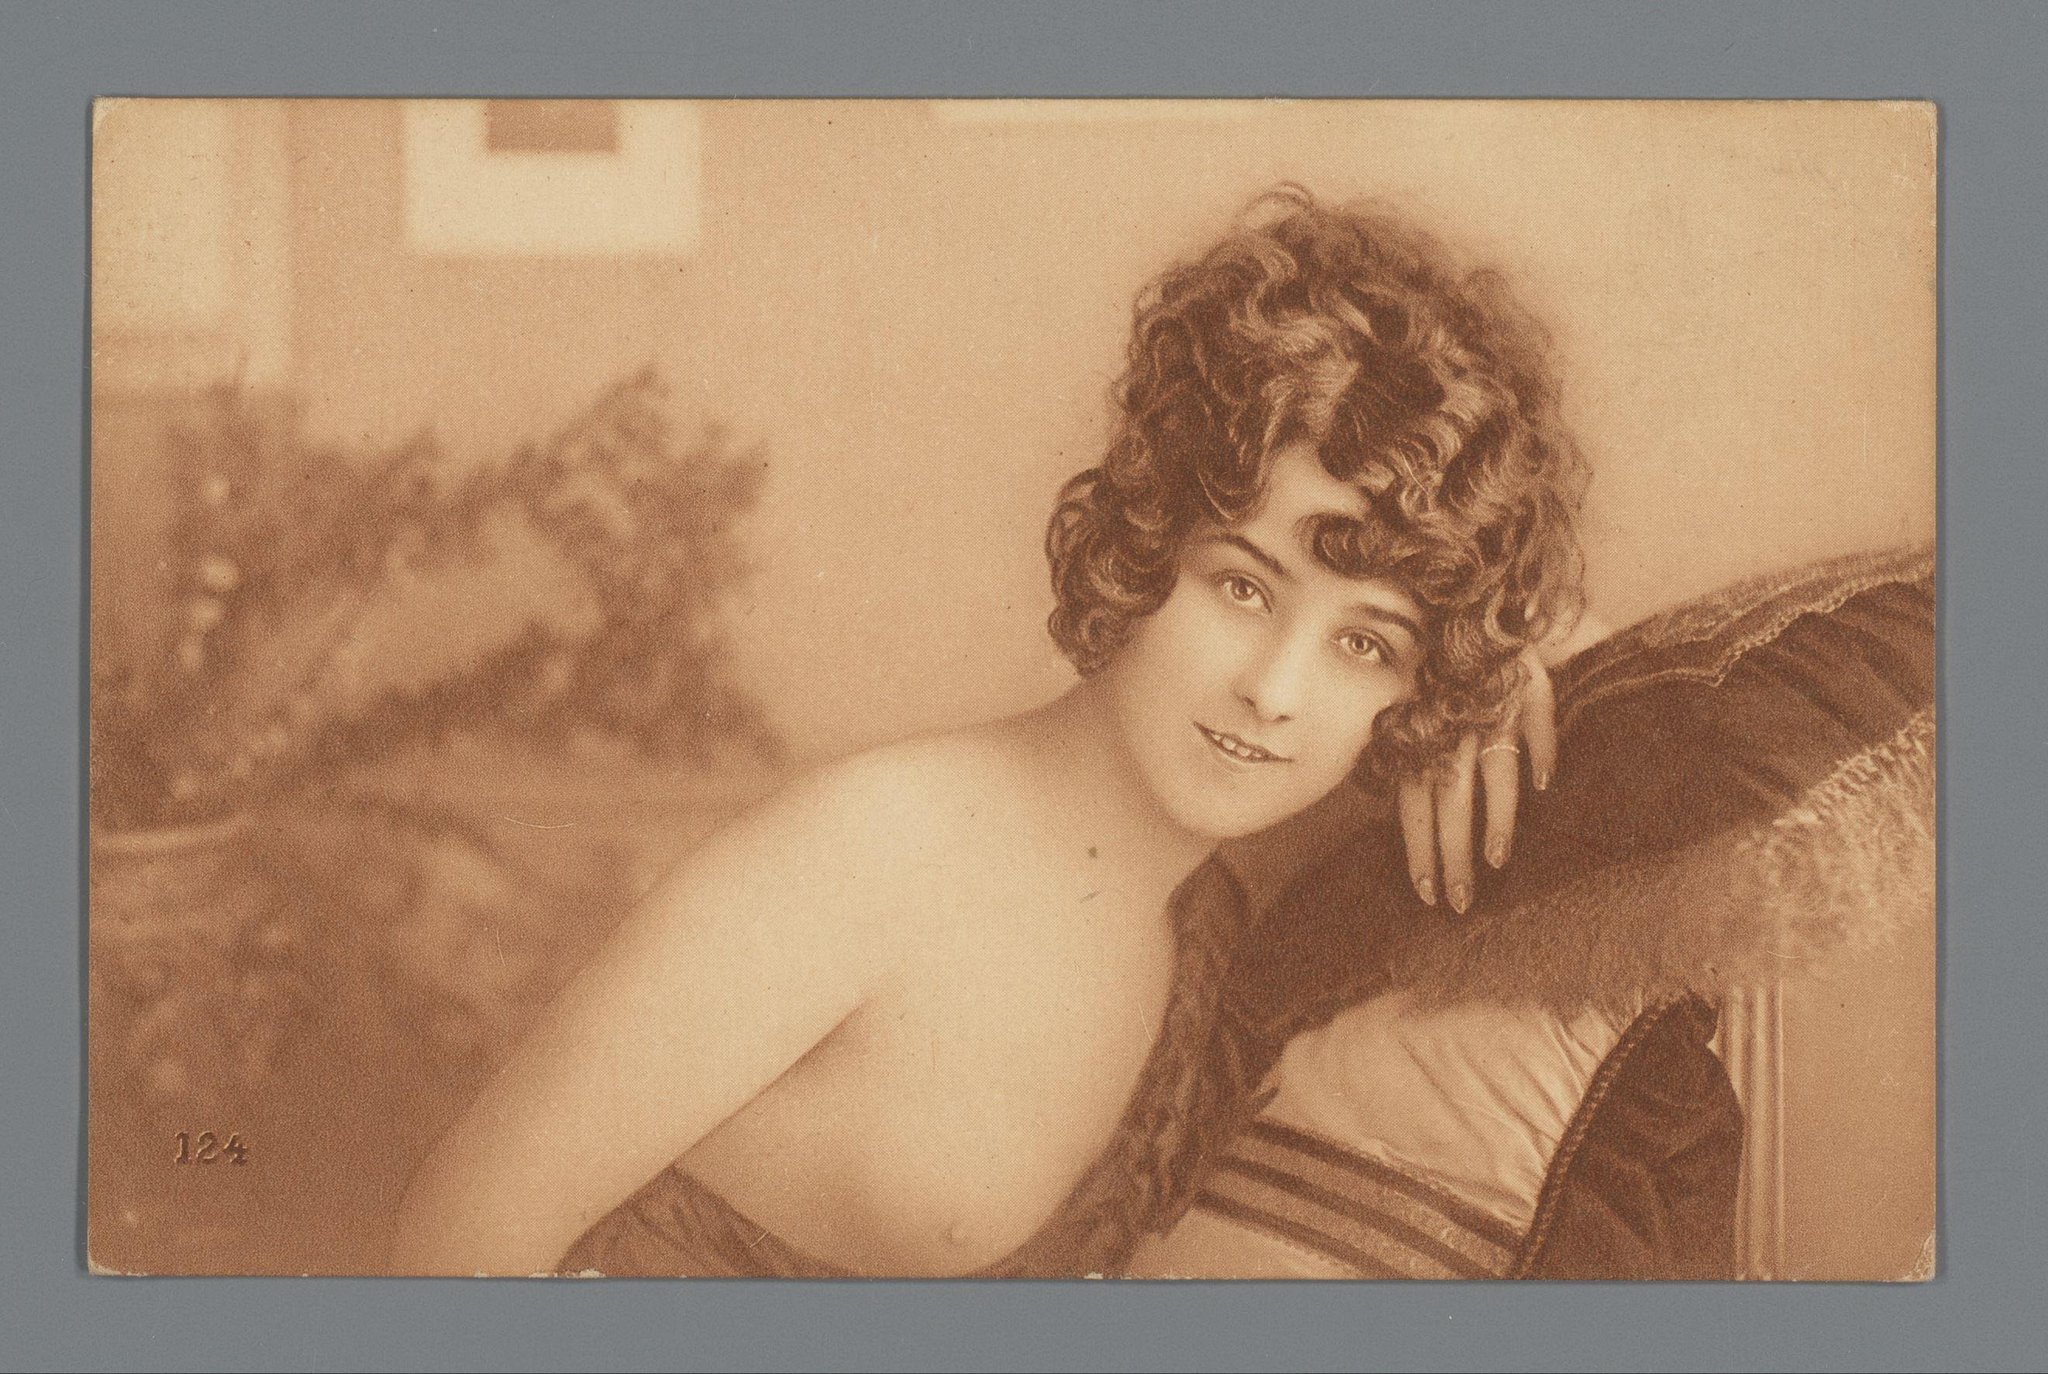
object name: photomechanical print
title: Portret van een onbekende vrouw met ontbloot bovenlijf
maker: Anonymous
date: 1913-1940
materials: cardboard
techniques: rotogravure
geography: france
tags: adult woman, anonymous historical person portrayed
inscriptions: inscription: ‘AUROGRAPHIE/ Fabrication Française’